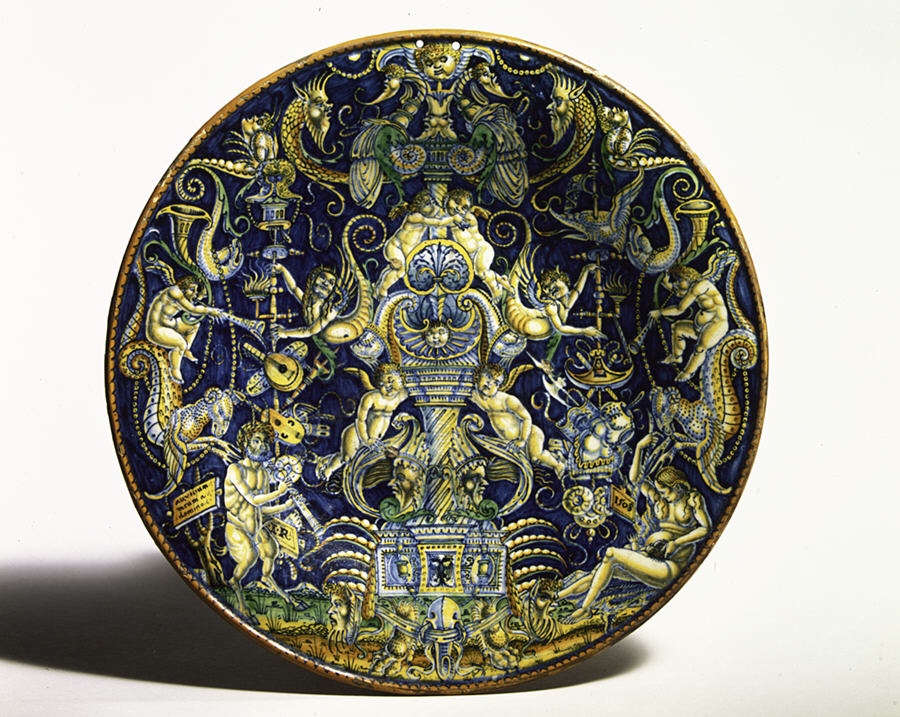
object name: plate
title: Plate (piatto)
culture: italian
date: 1508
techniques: maiolica, glazing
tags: female nudes,putti,satyrs